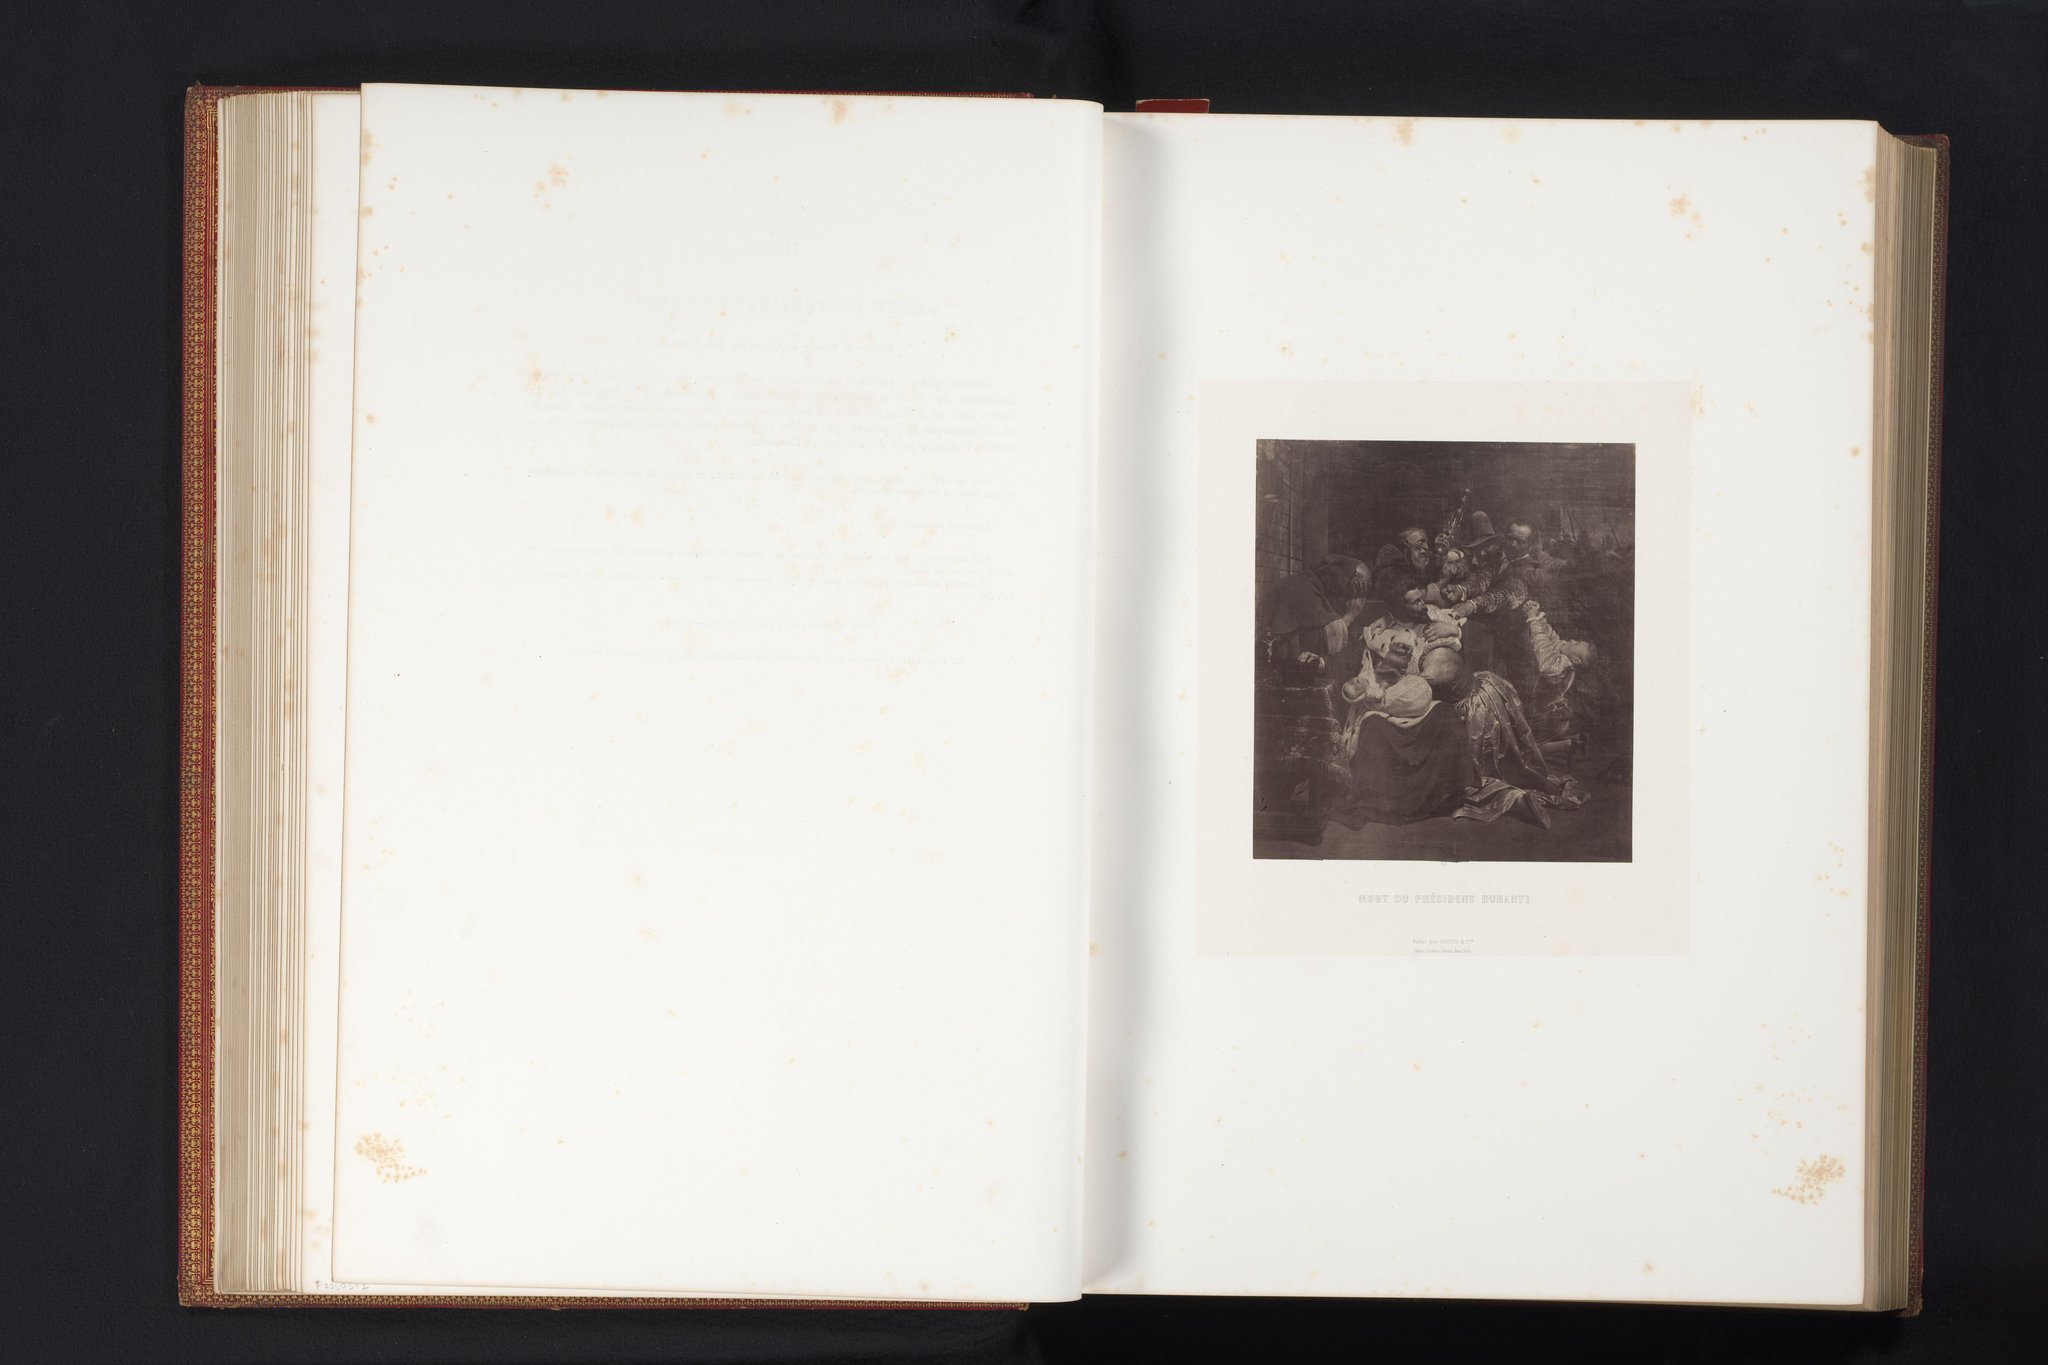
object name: photograph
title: Fotoreproductie van een schilderij van de dood van Jean-Étienne Duranti door Paul Delaroche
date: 1853-1858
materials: paper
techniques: albumen print, engraving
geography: paris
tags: politician, violent death, being killed; being mishandled and maltreated; seeking death, attempt, political murder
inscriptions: check stamp: ‘GC’